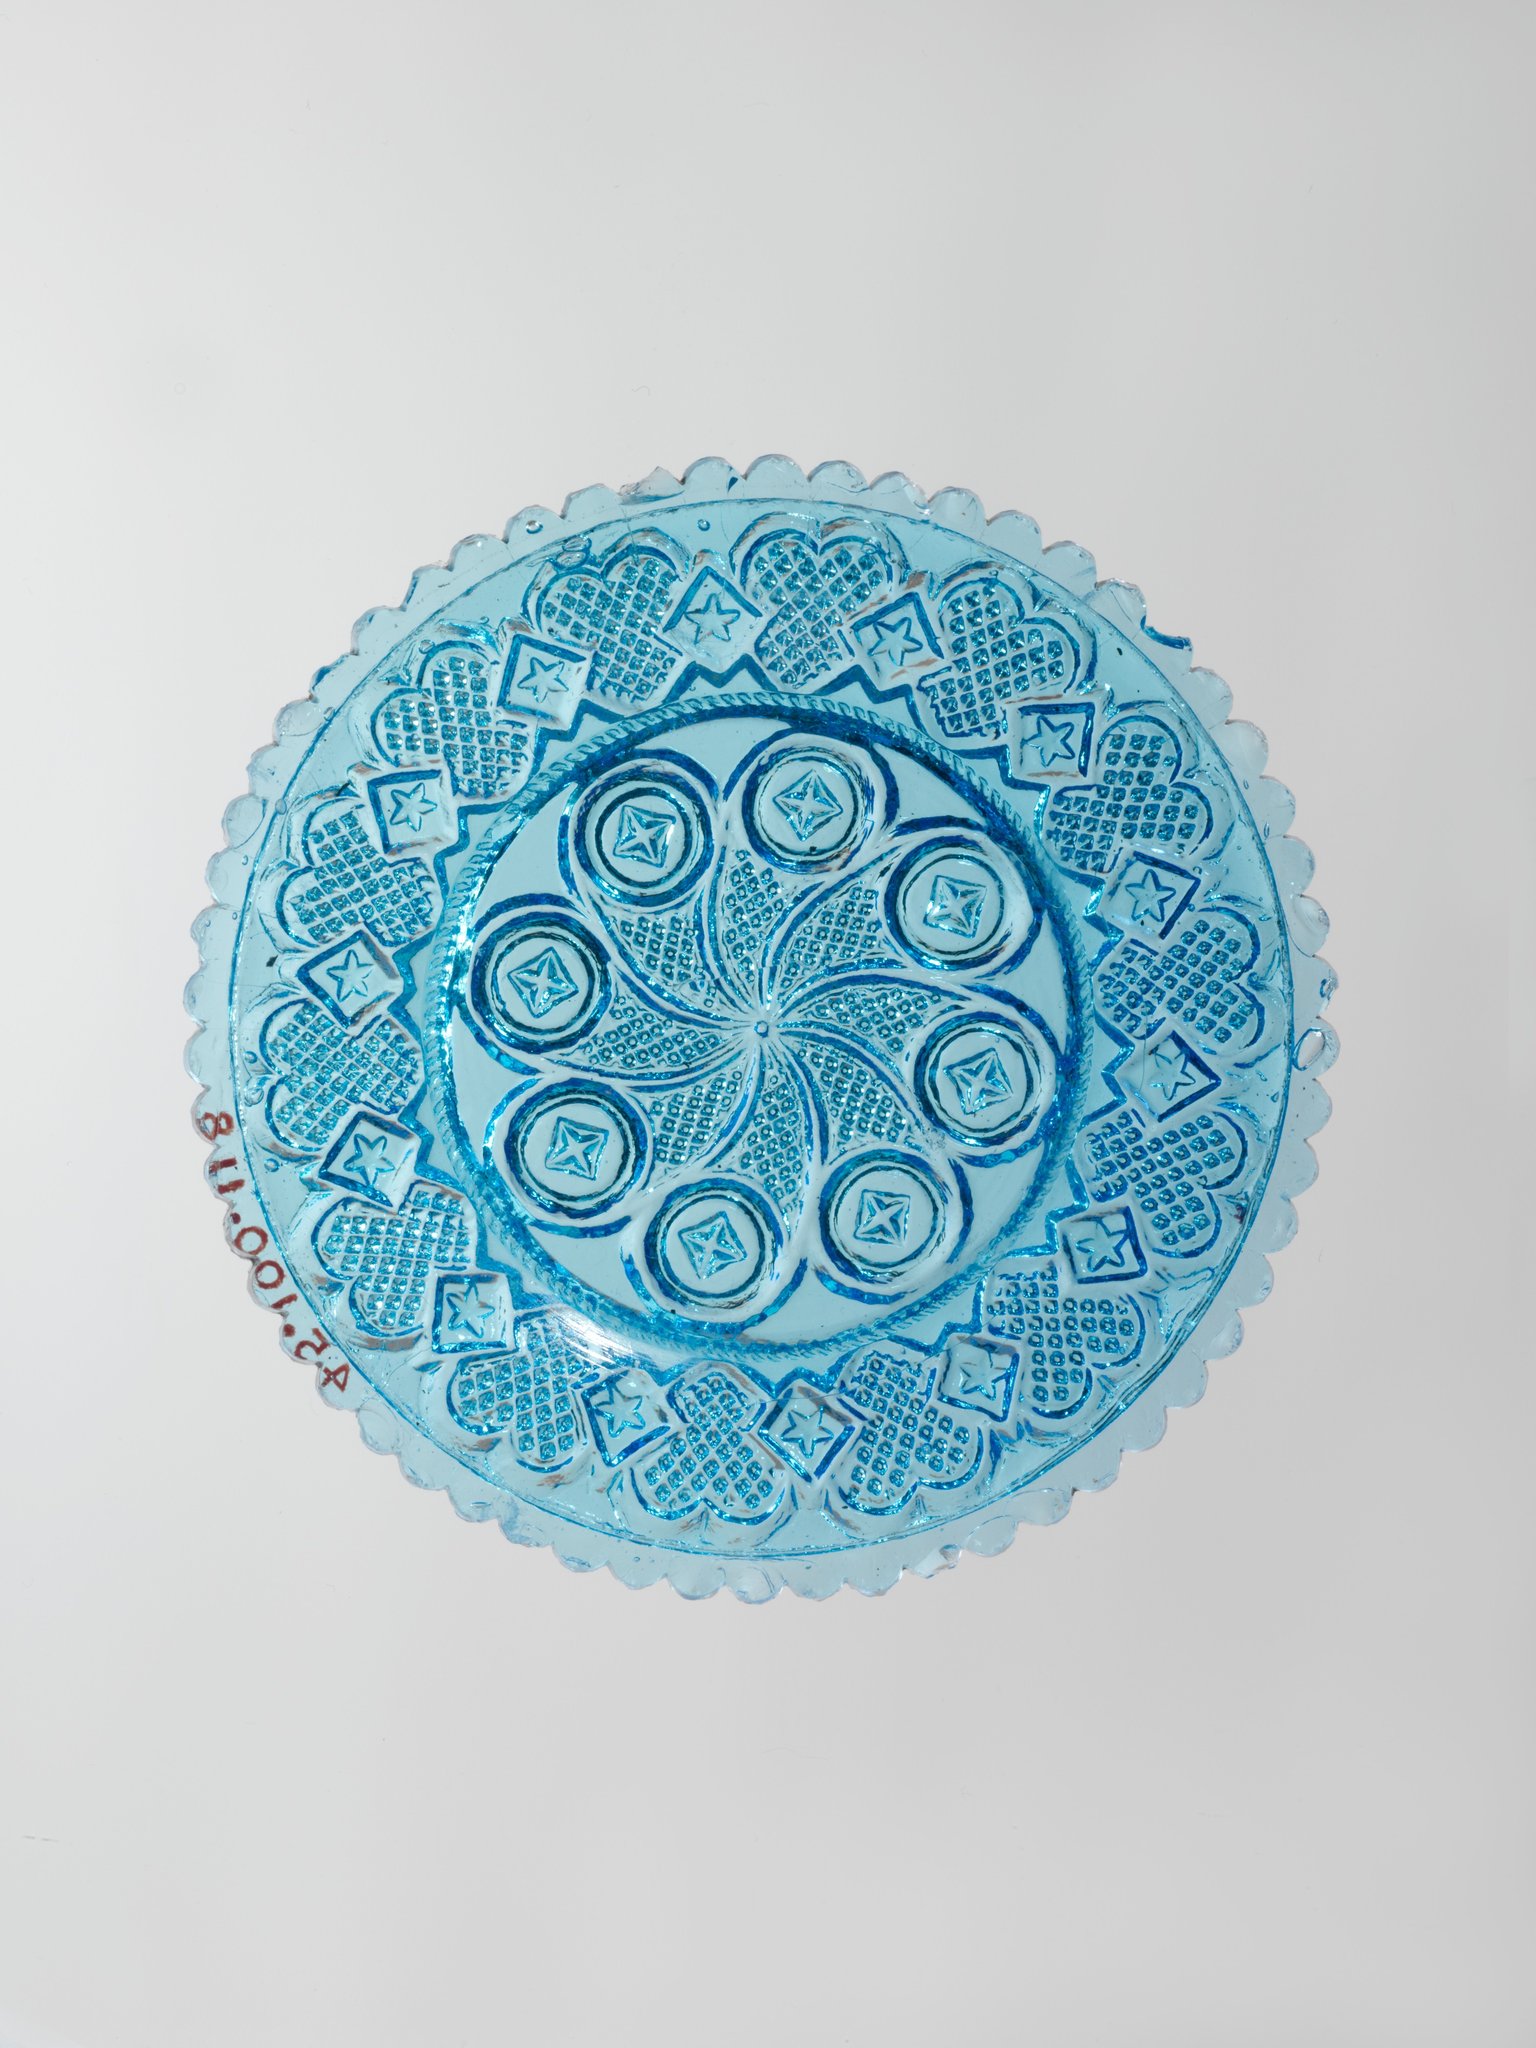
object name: cup plate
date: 1825-1860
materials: glass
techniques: pressed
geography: united states